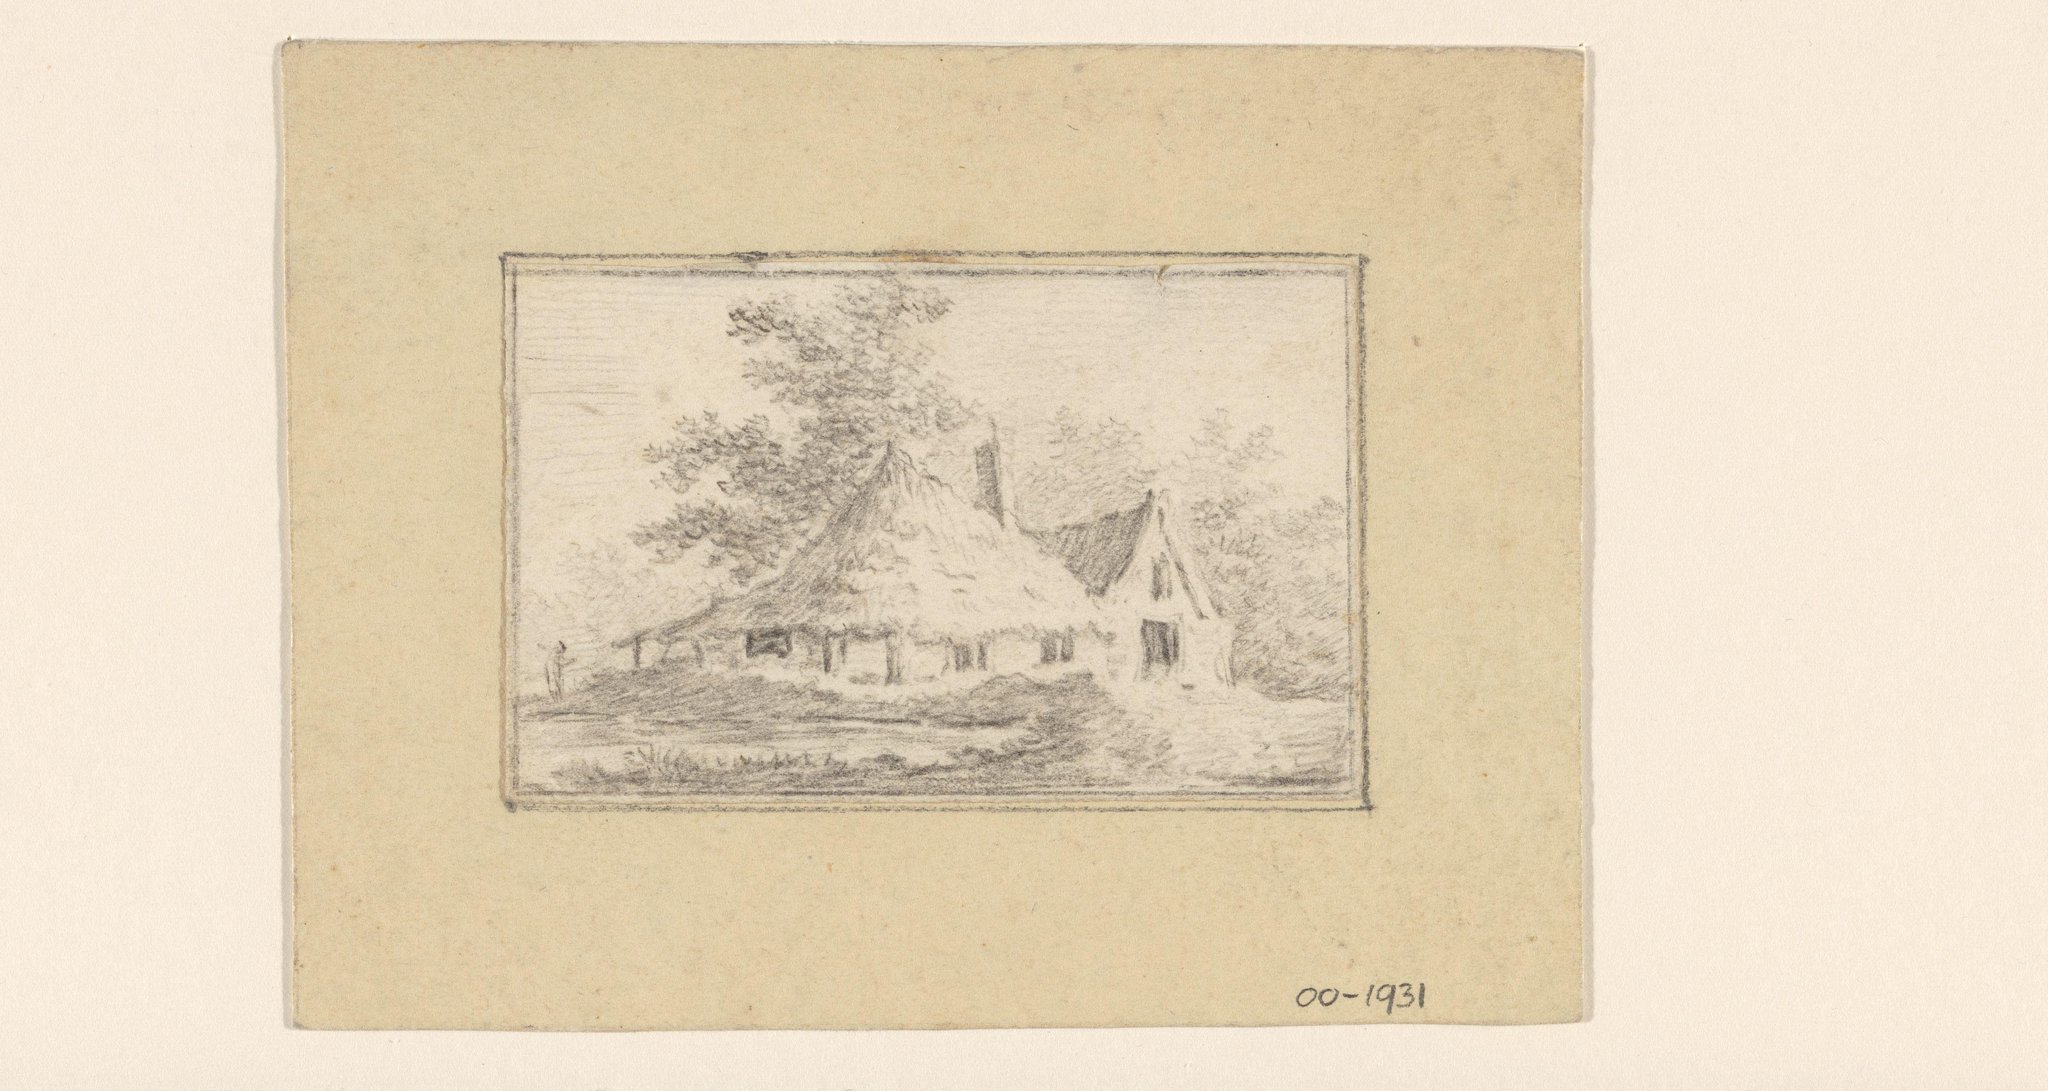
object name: drawing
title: Boerenwoning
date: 1700-1800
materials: chalk, paper